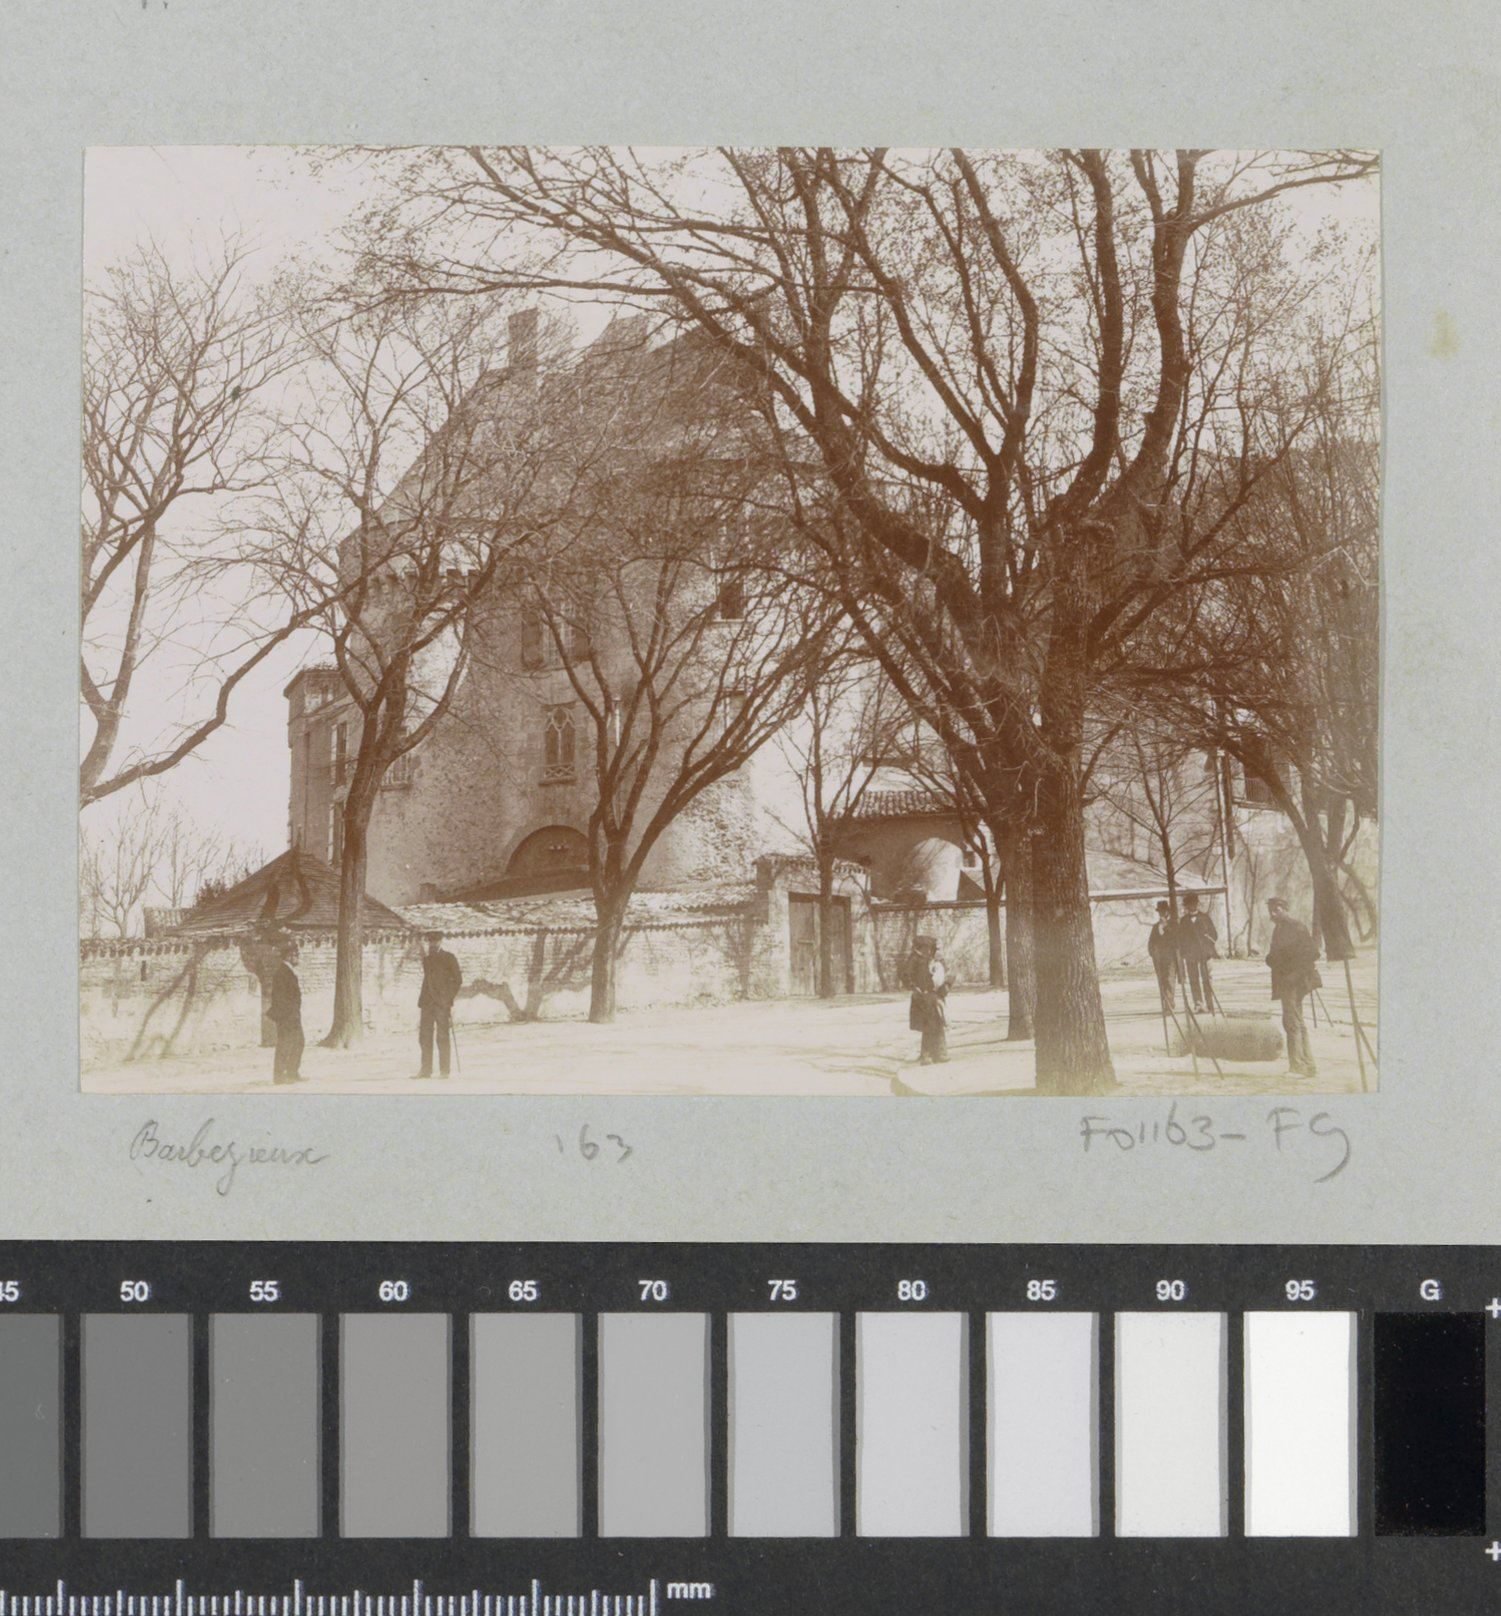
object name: photograph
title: Kasteel van Barbezieux door de bomen gezien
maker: delizy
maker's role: manufacturer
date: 1898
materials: paper, photographic support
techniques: gelatin silver print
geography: barbezieux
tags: castle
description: Onderdeel van Fotoalbum van een Franse amateurfotograaf met opnames van uitstapjes in Frankrijk, Spanje, België, Luxemburg en Nederland, de eerste automobielen en autoraces.